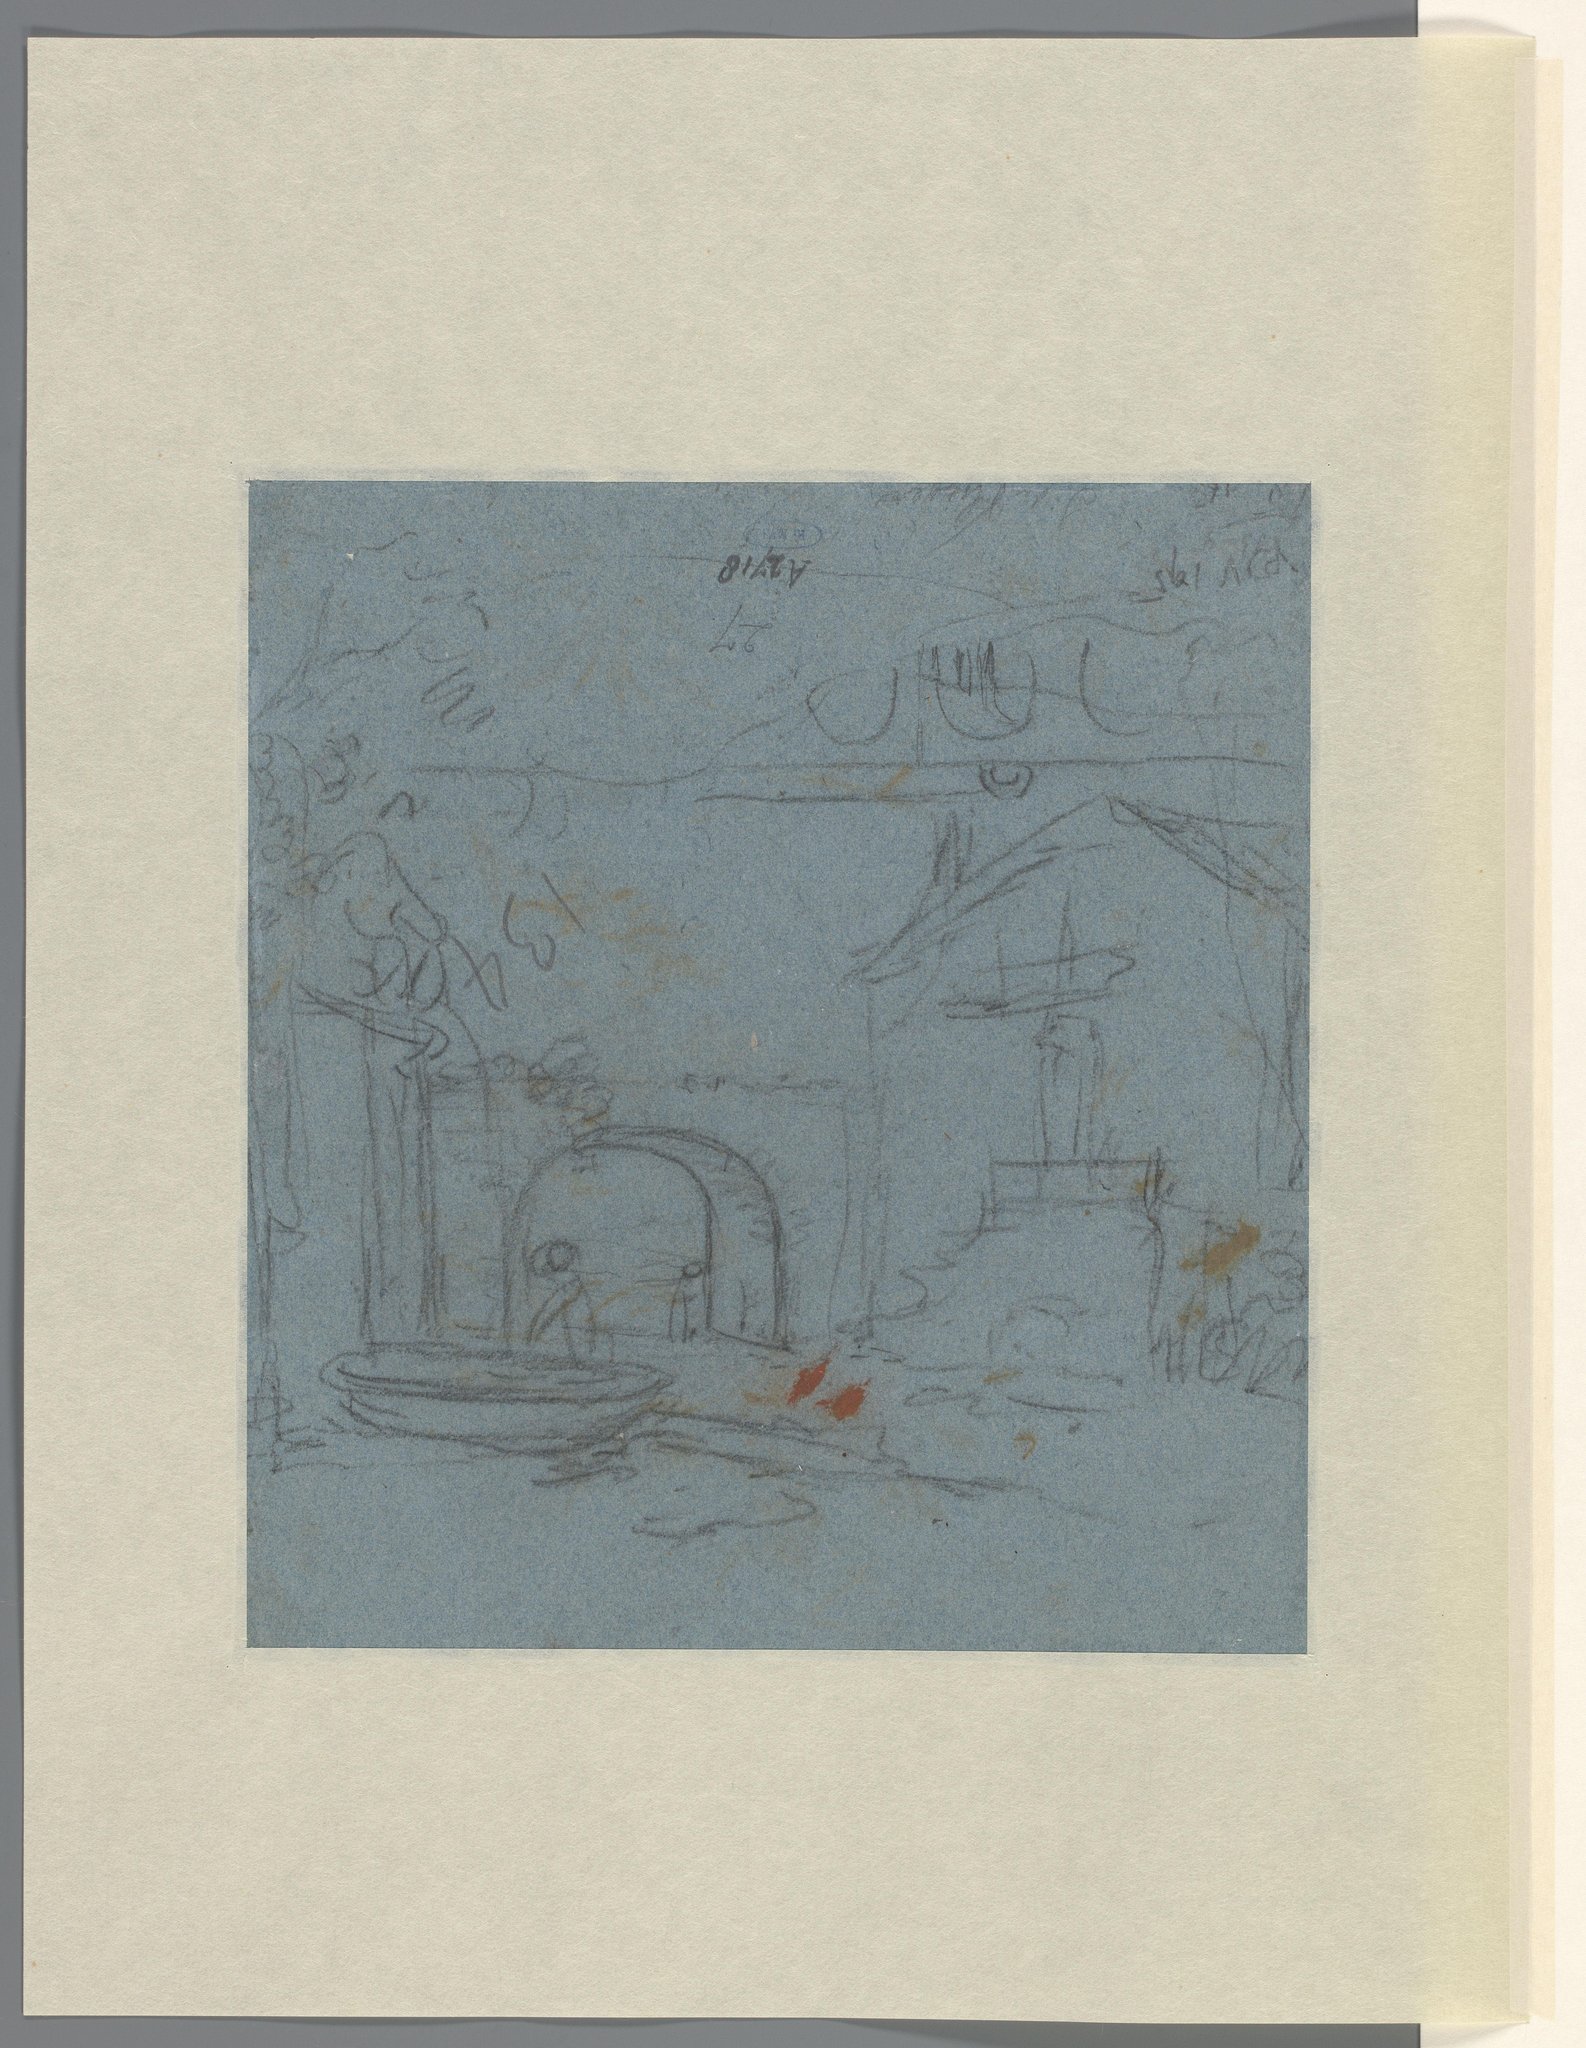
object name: drawing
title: Studieblad met schetsen van een straat of binnenplaats en van een brug met bogen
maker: simon de vlieger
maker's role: draughtsman, painter, print maker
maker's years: 1600-1653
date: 1610-1653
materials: chalk, paper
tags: courtyard, street